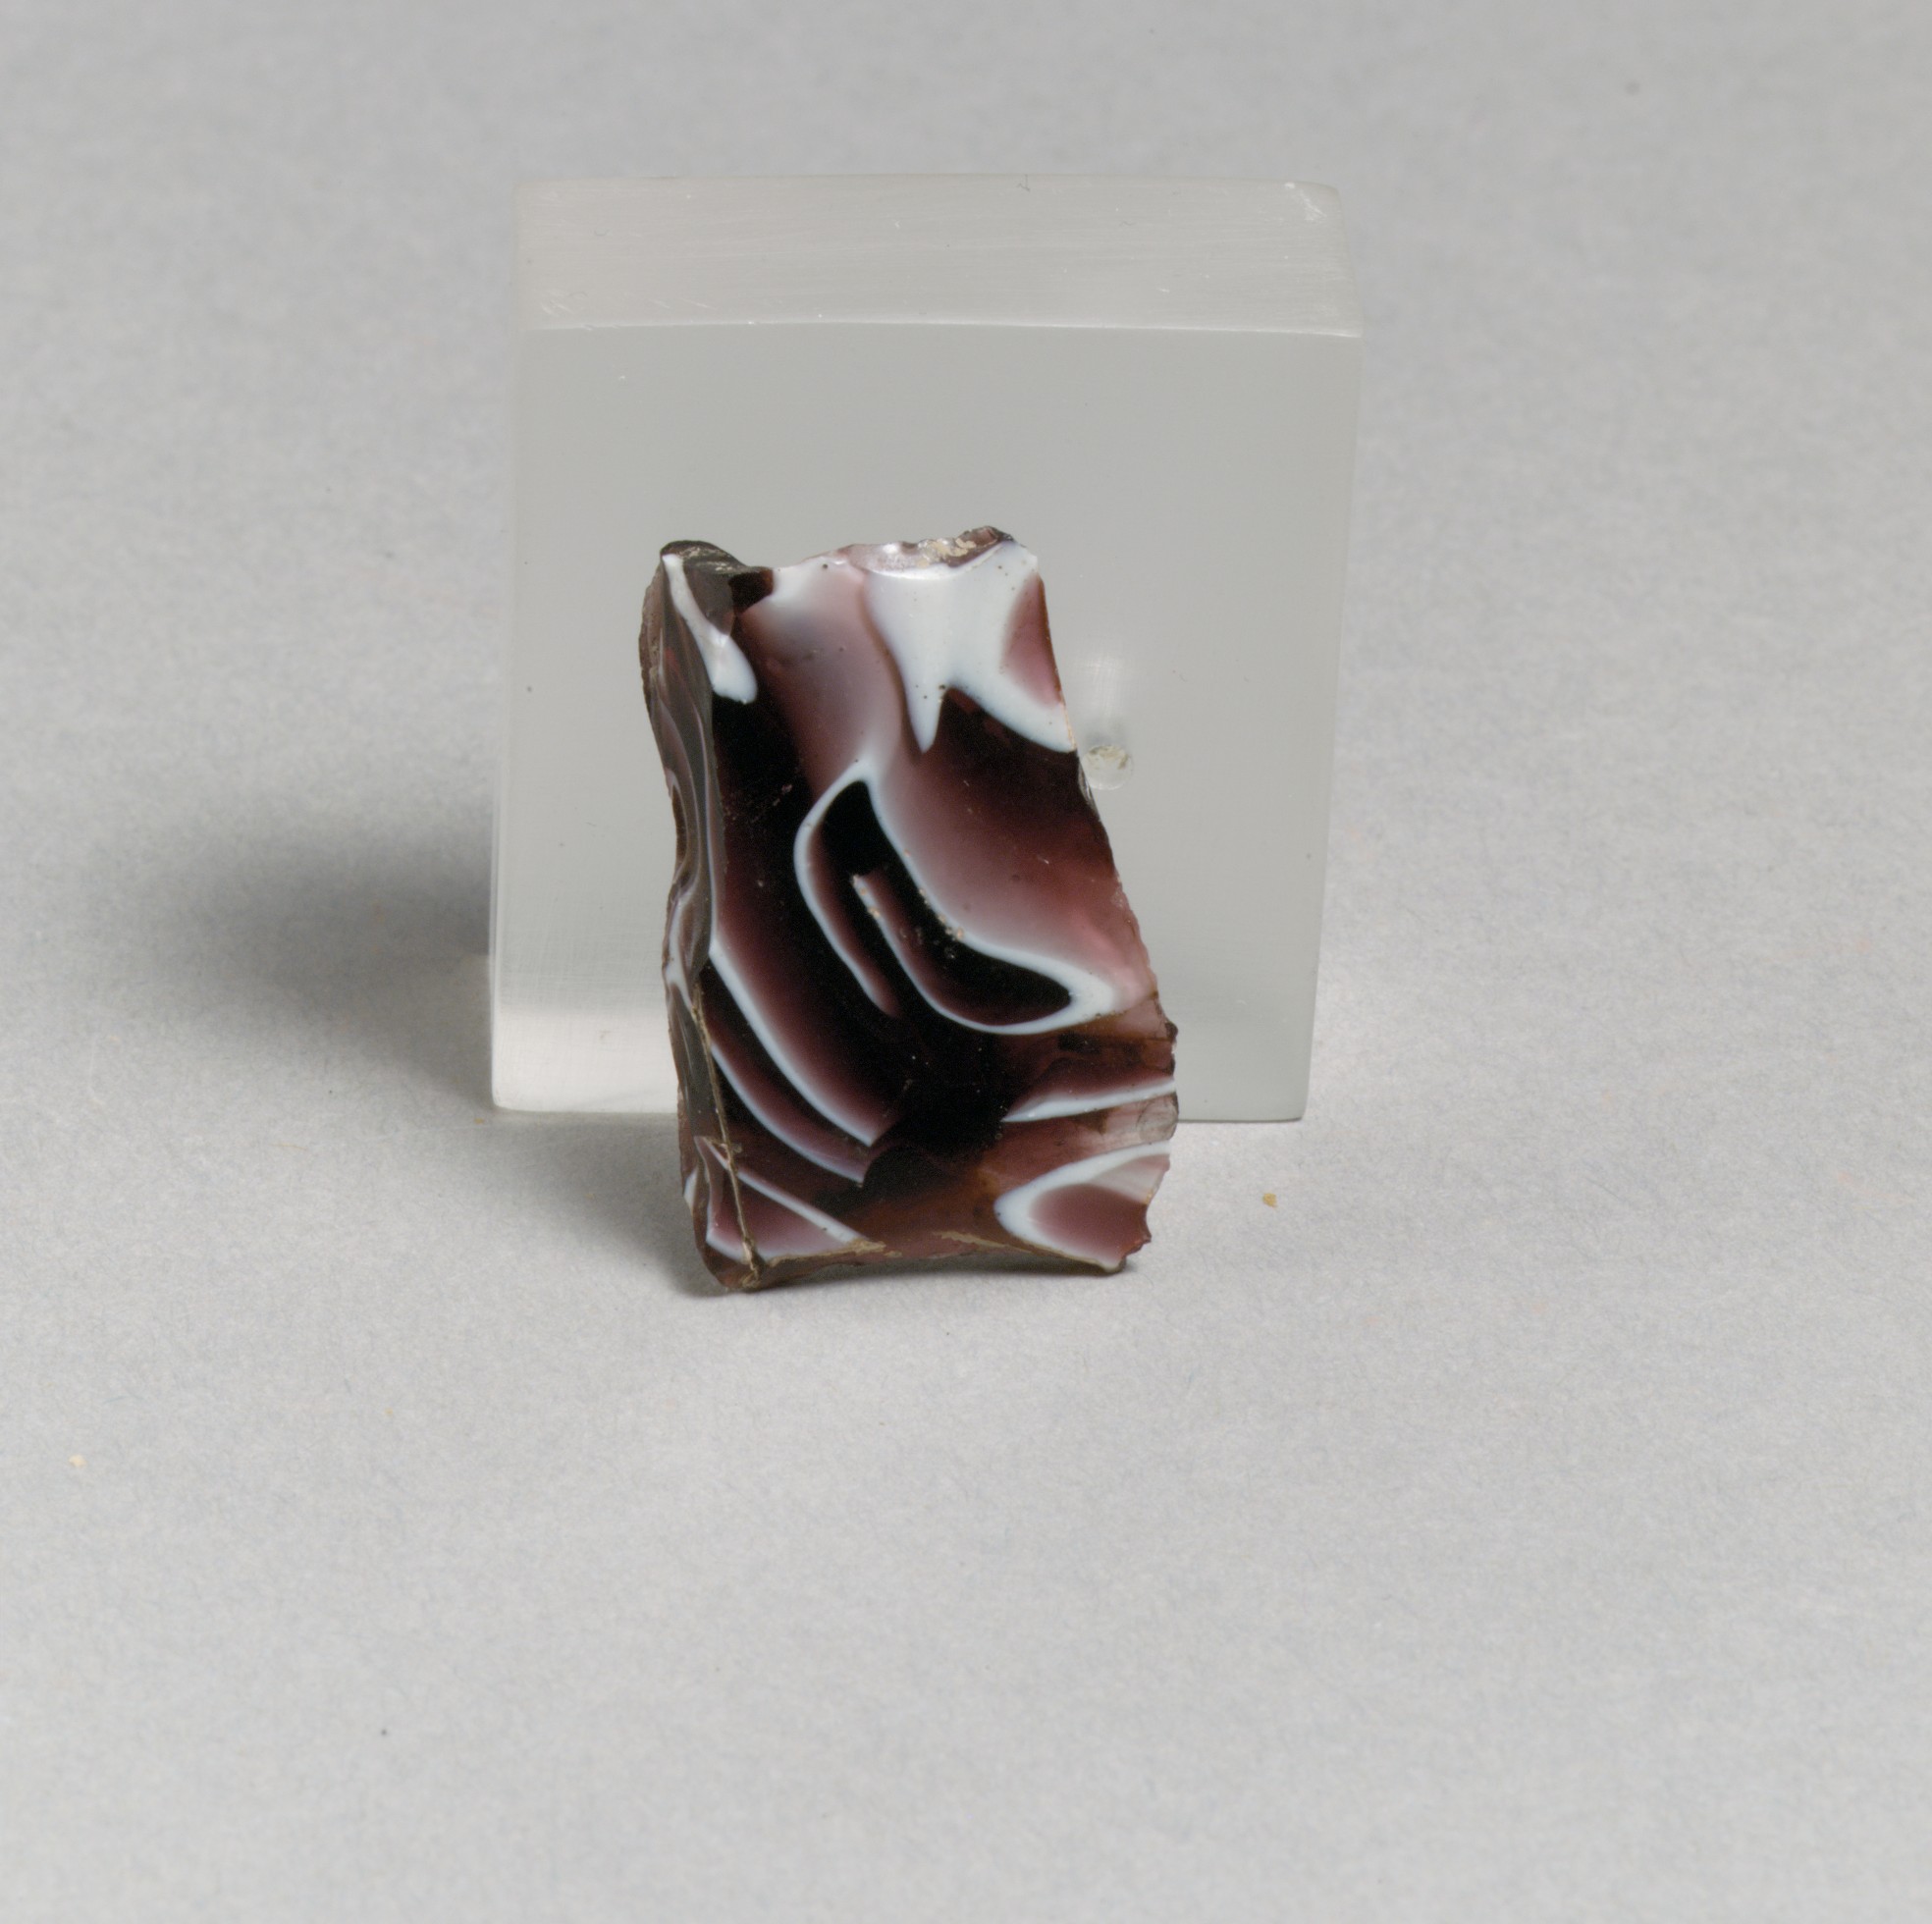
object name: fragment, mosaic bowl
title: Glass mosaic ribbed bowl fragment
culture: roman, italian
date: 34 BCE-33 CE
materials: glass